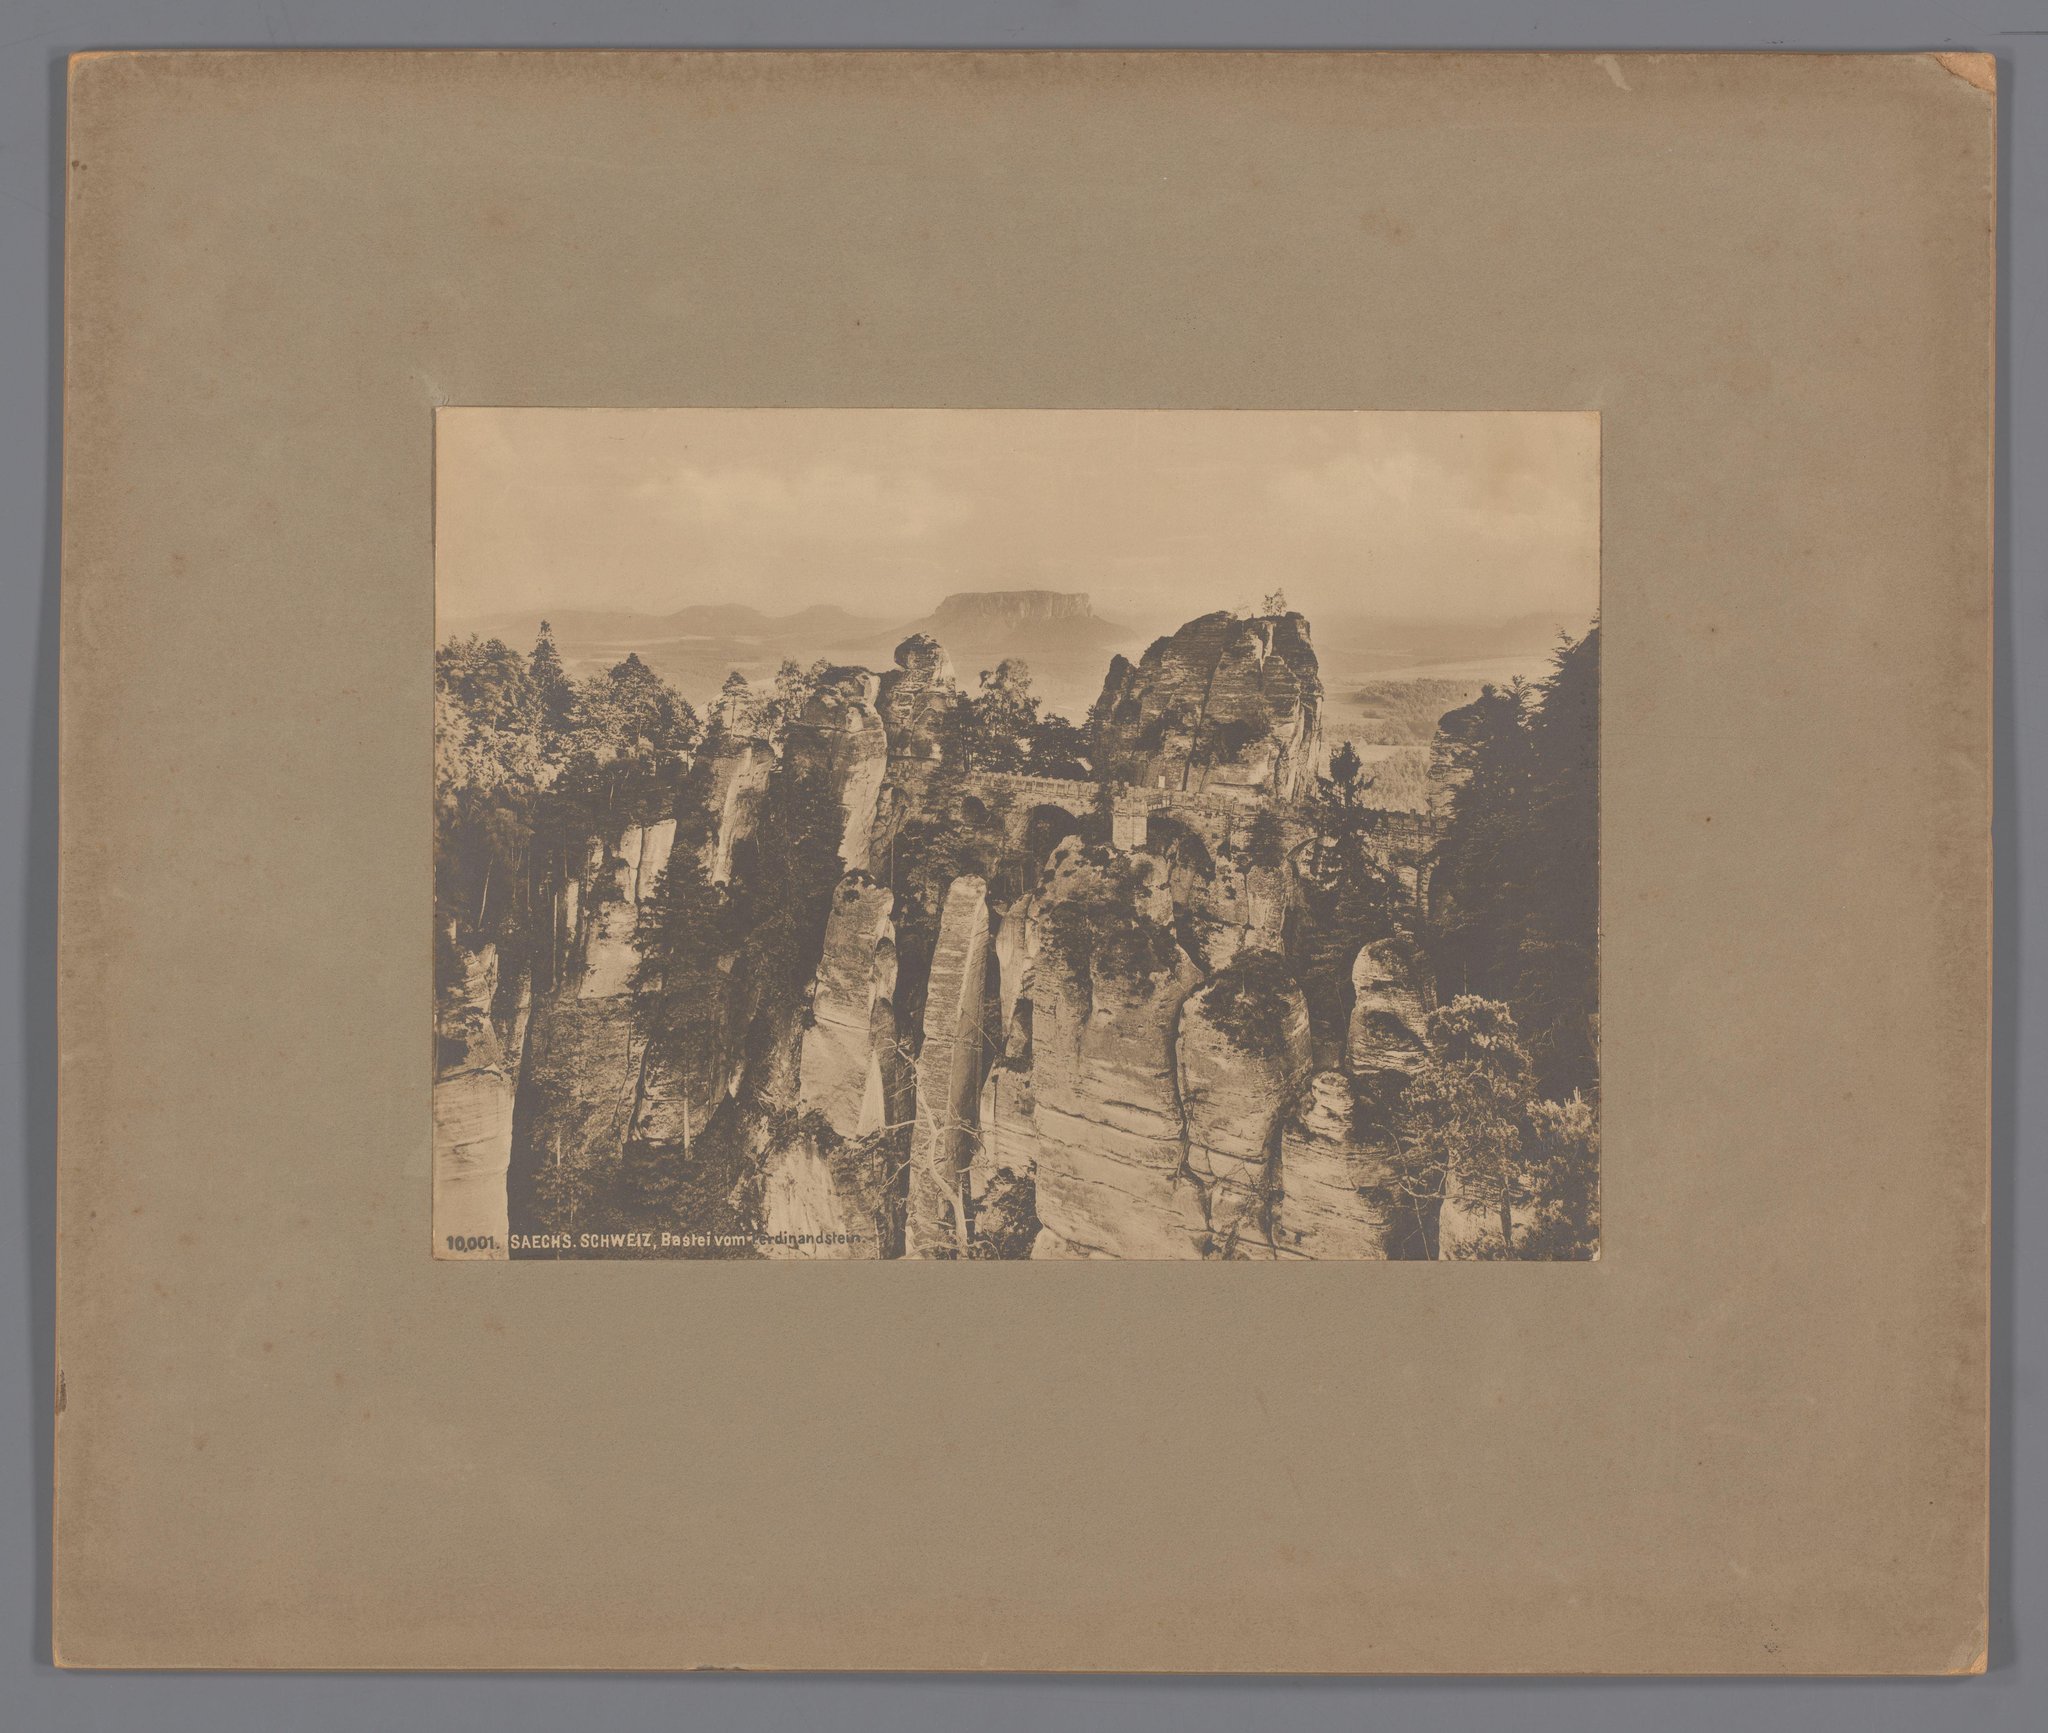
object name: photograph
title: Bastei vanaf de Ferdinandstein, Sächsische Schweiz, Duistland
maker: Anonymous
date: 1903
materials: cardboard, paper, photographic support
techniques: gelatin silver print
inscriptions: inscription: ‘10,001 SAECHS. SCHWEIZ, Bastei vom Ferdnindstein.’, check stamp: ‘Th. [...-]maier’, number: ‘1903’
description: Sächsische Schweiz (Saksisch Zwitserland) is een voormalig district (Landkreis) in de Duitse deelstaat Saksen en tevens de naam voor de streek in het Elbsandsteingebirge tussen Dresden en de Tsjechische grens. Hier zien we de ‘Brug van Bastei’, een natuurwonder van enkele markante rotspunten met een door de mens aangelegde stenen brug.